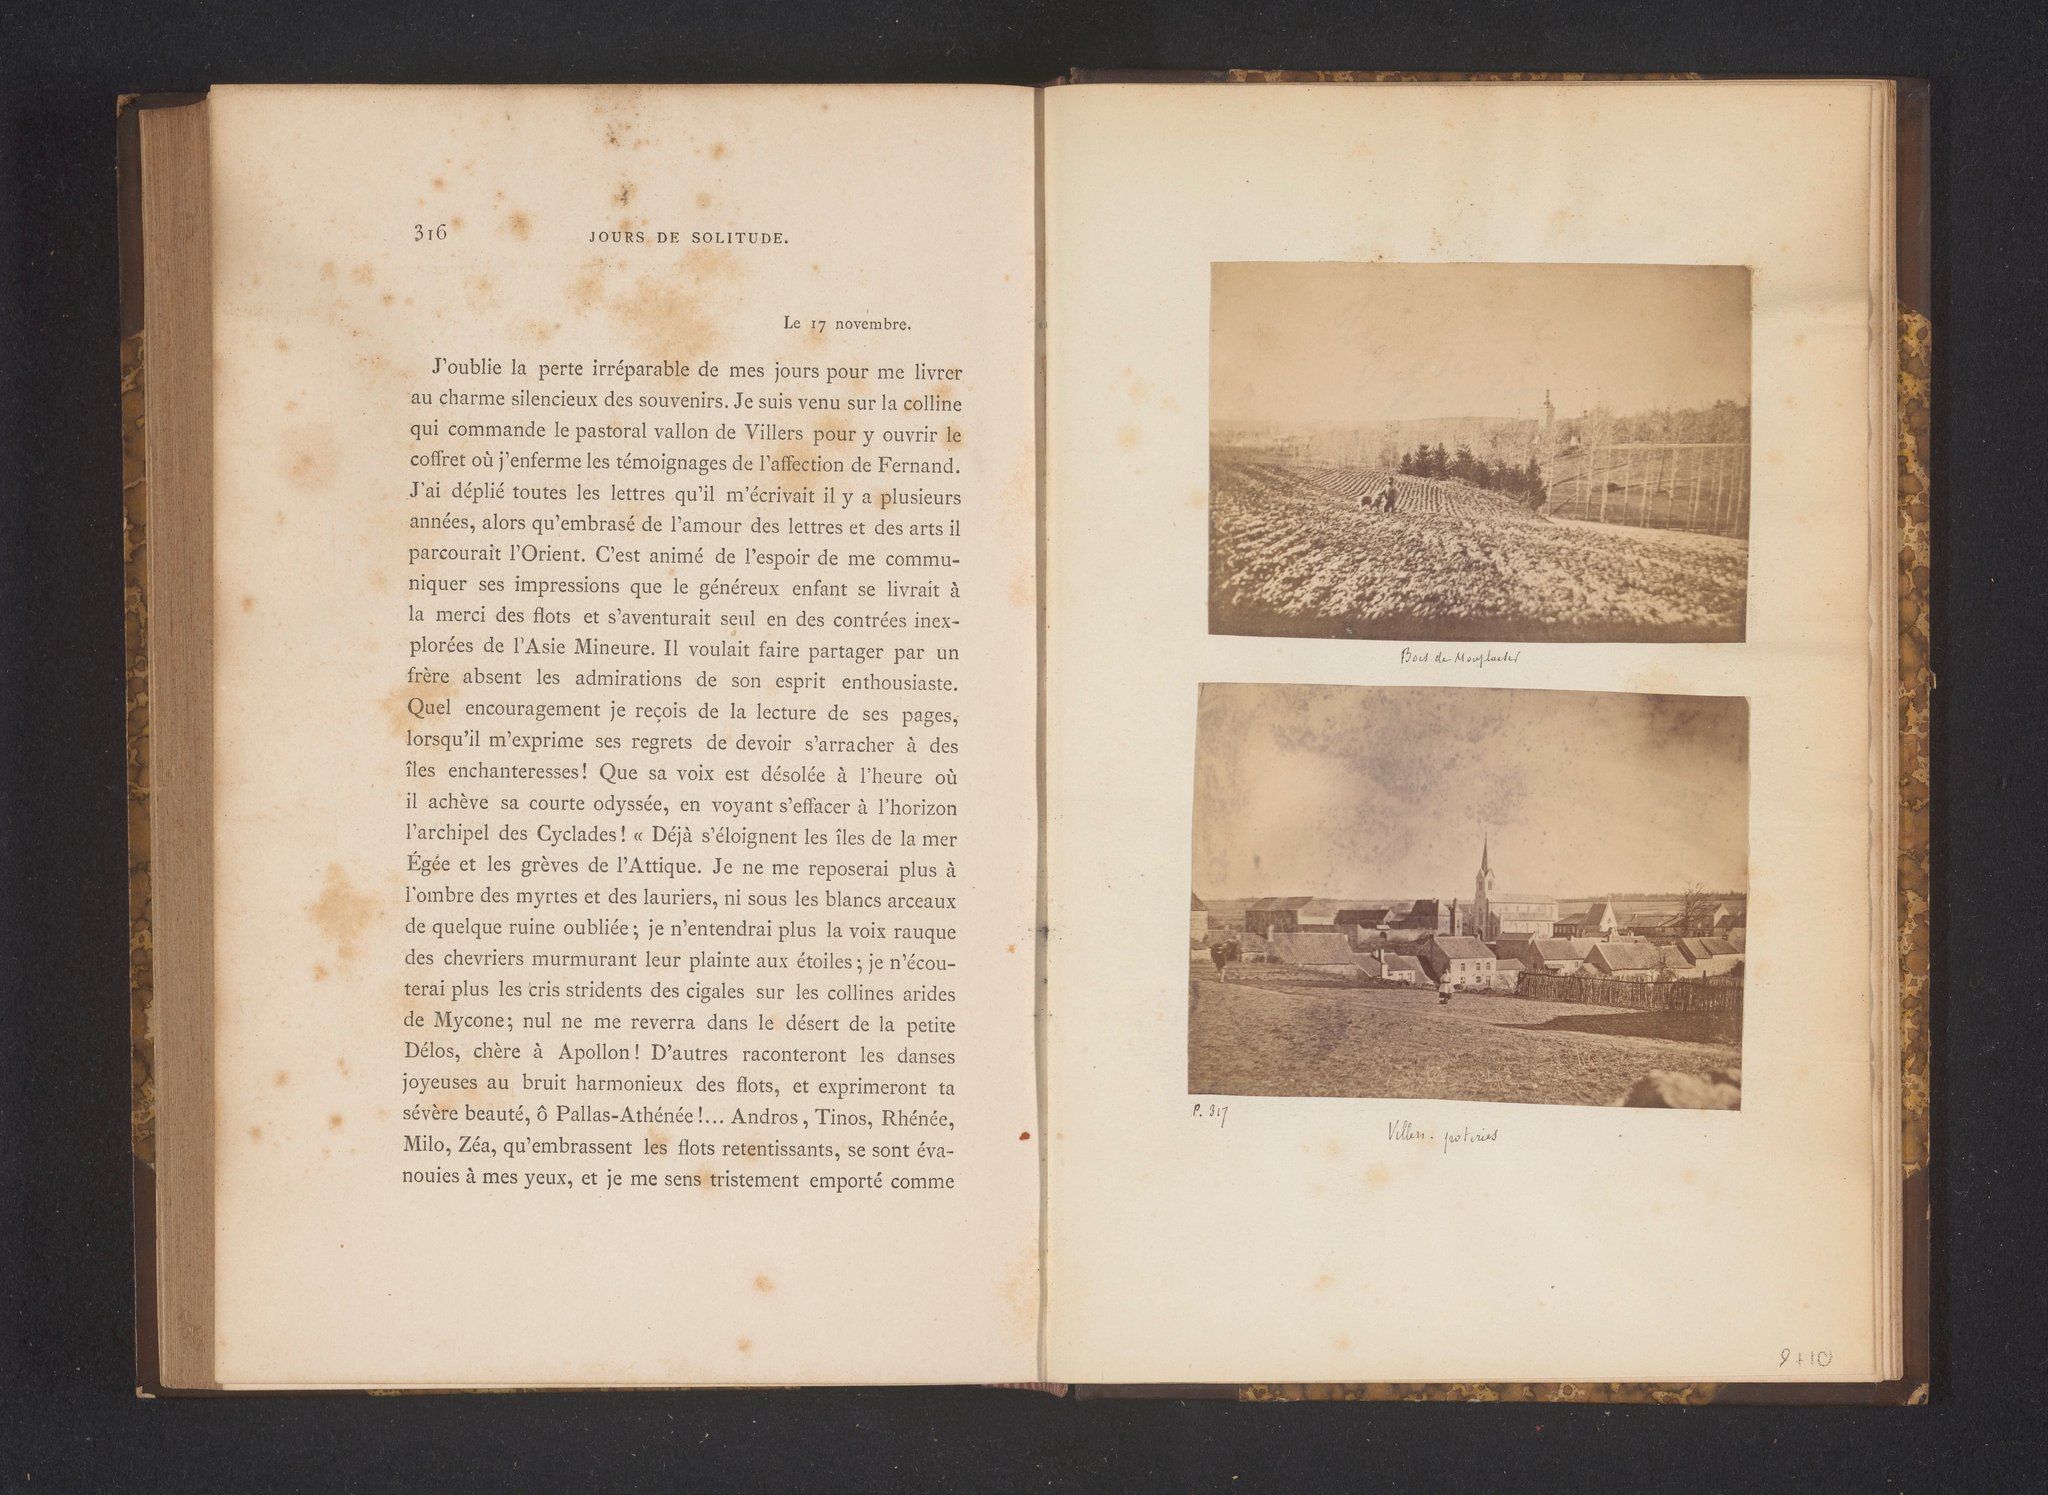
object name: photograph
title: Gezicht op een onbekend persoon op een akker met op de achtergrond een dorp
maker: Anonymous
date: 1872-1877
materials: photographic support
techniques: albumen print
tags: city-view in general; 'veduta', historical persons, cultivated land, belgium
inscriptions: inscription: ‘Villers poteries’